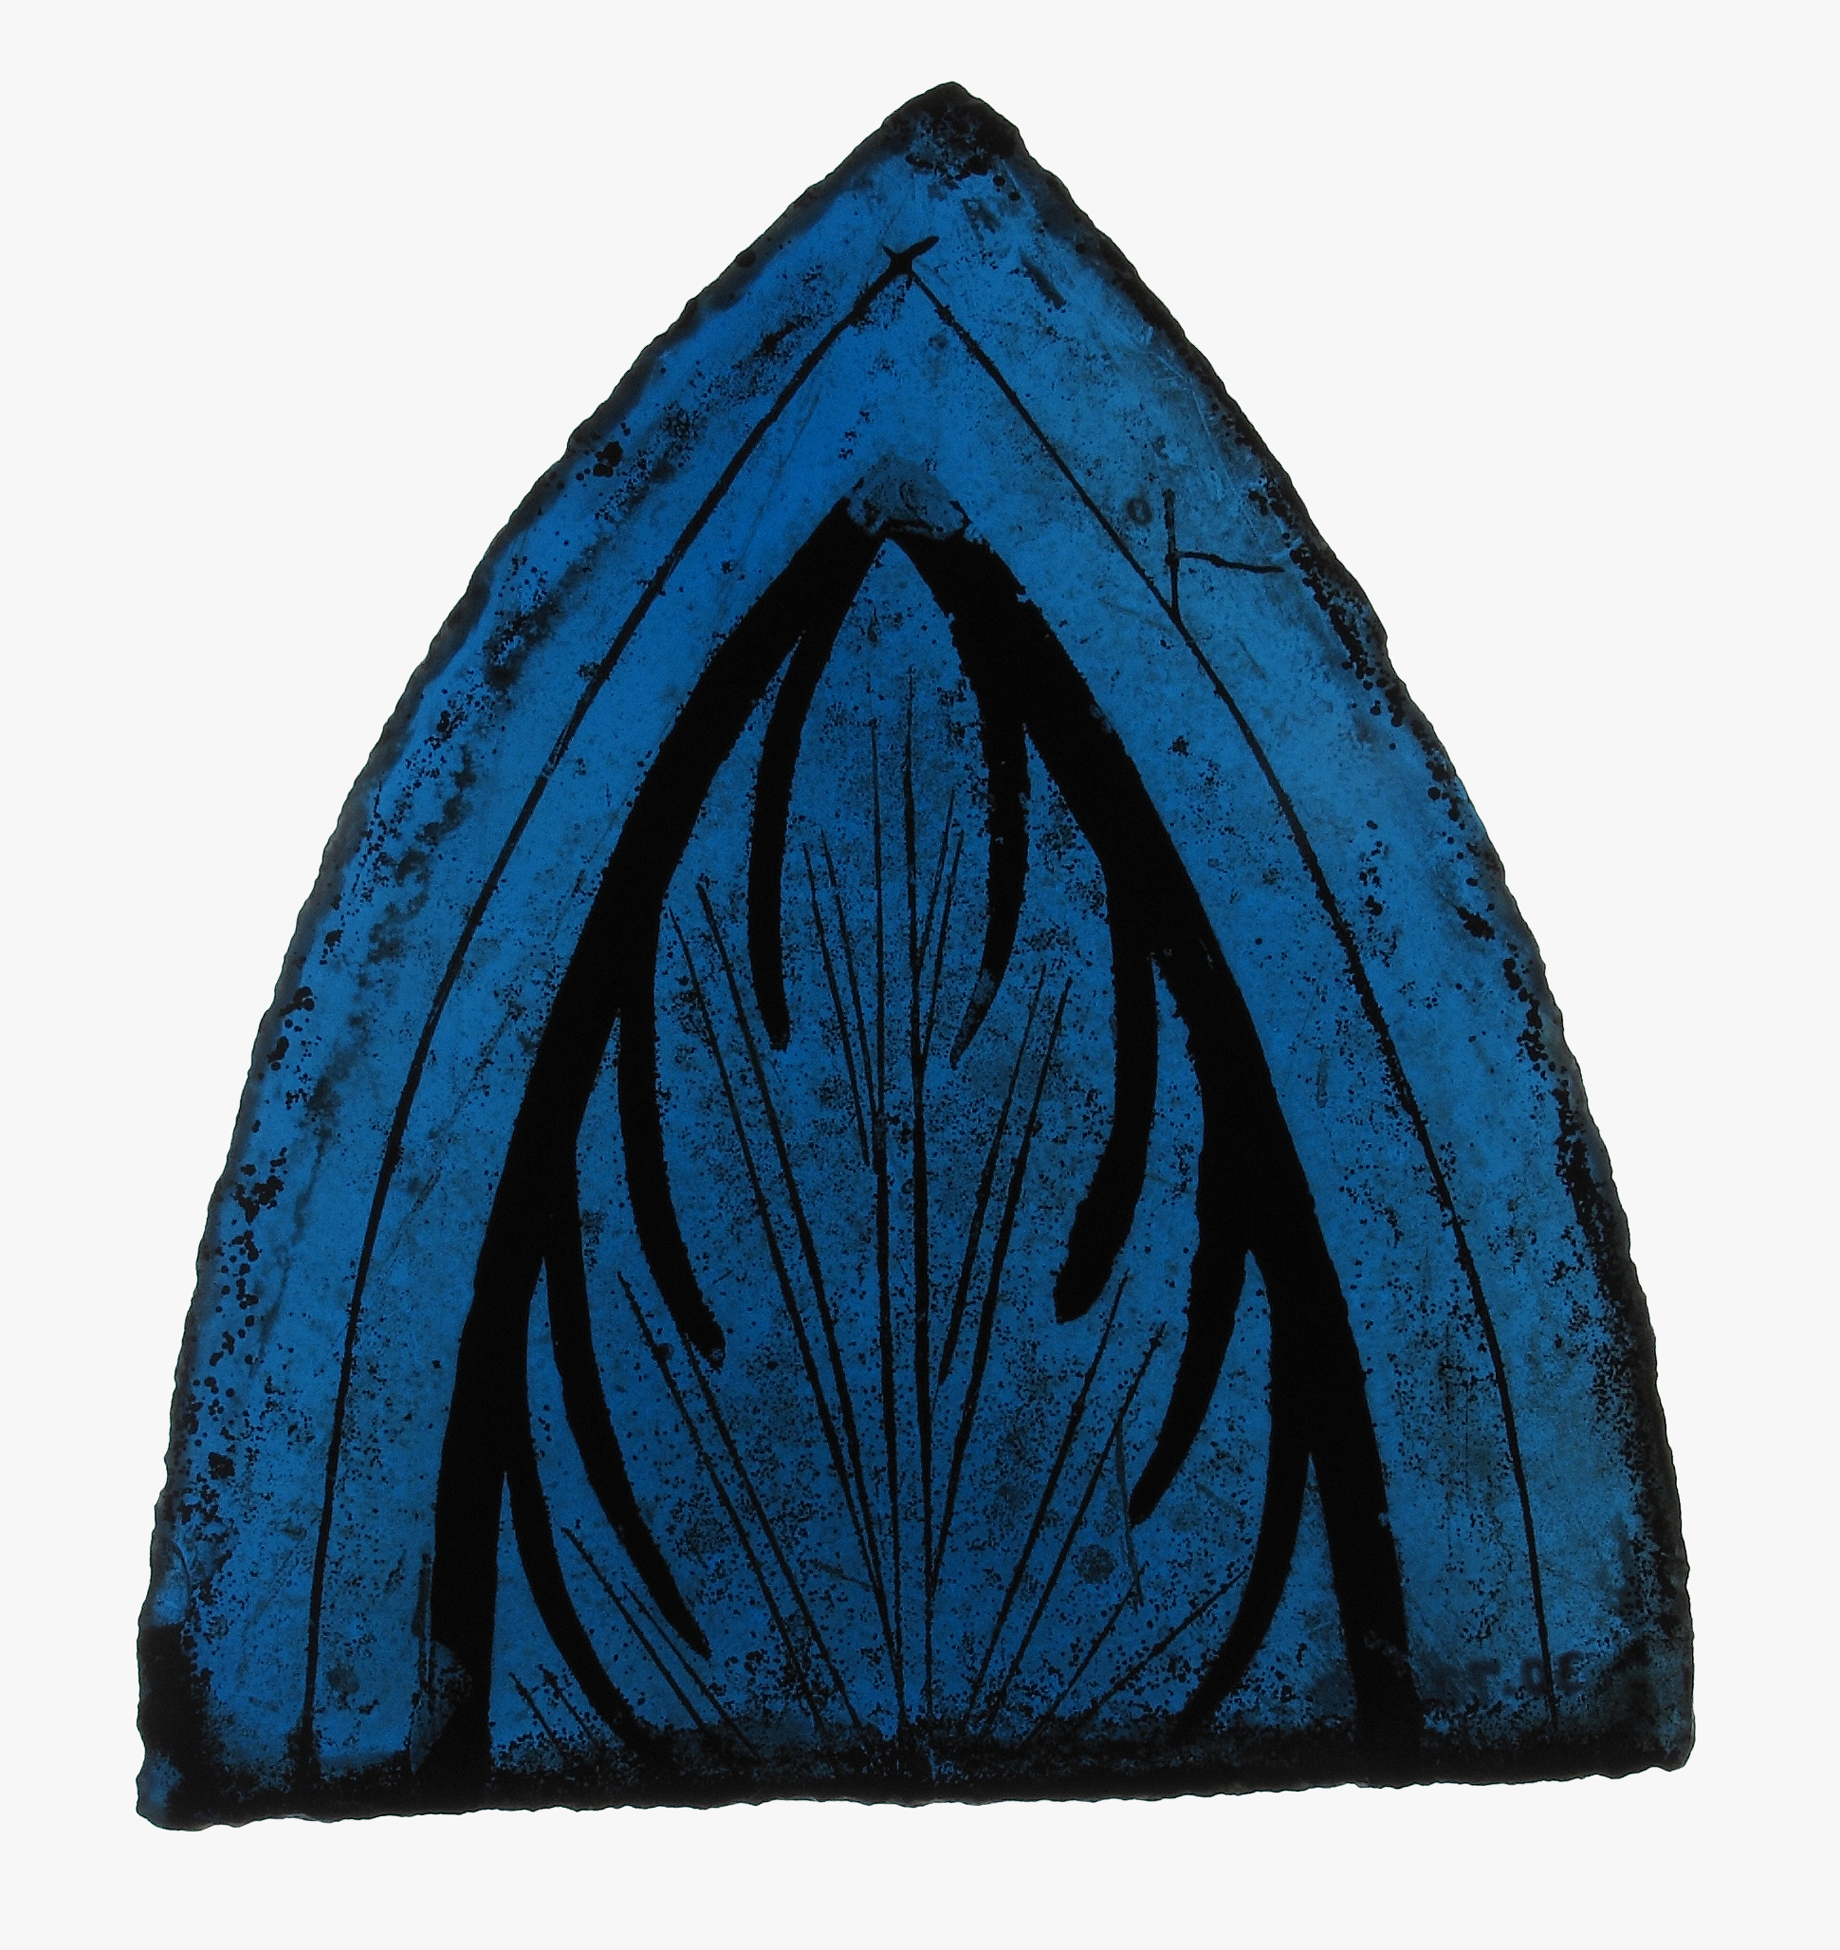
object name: fragment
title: Glass Fragment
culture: european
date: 1267-1300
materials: glass, metal